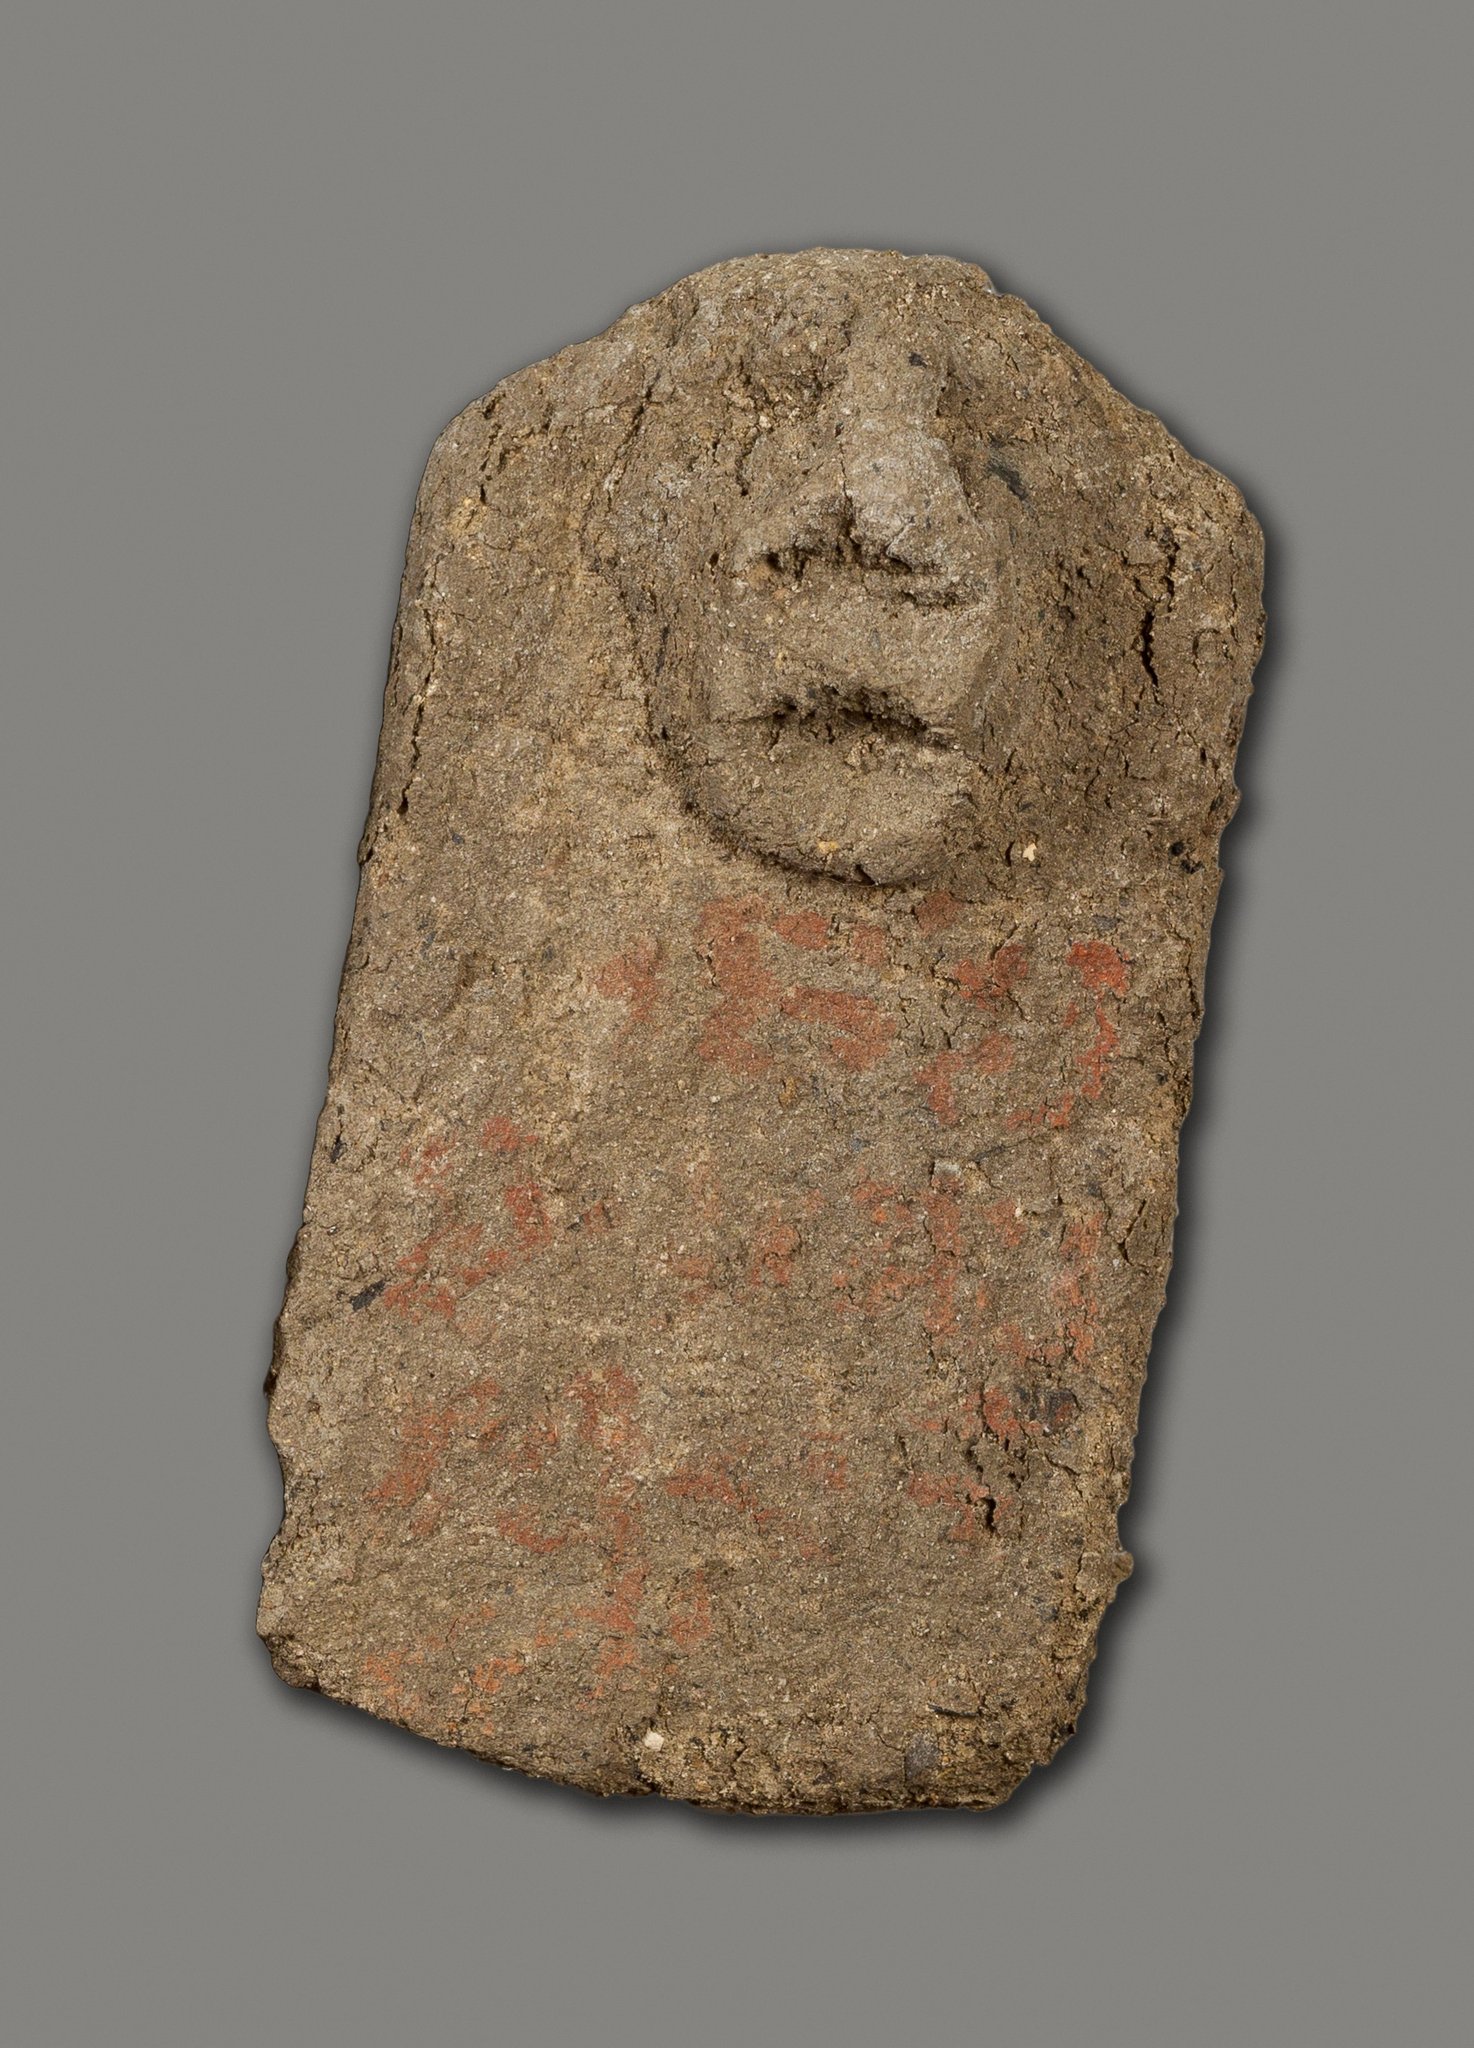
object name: figure, magical, execration, tablet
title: Magical Figure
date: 1802-1550 BCE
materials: clay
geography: egypt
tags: faces